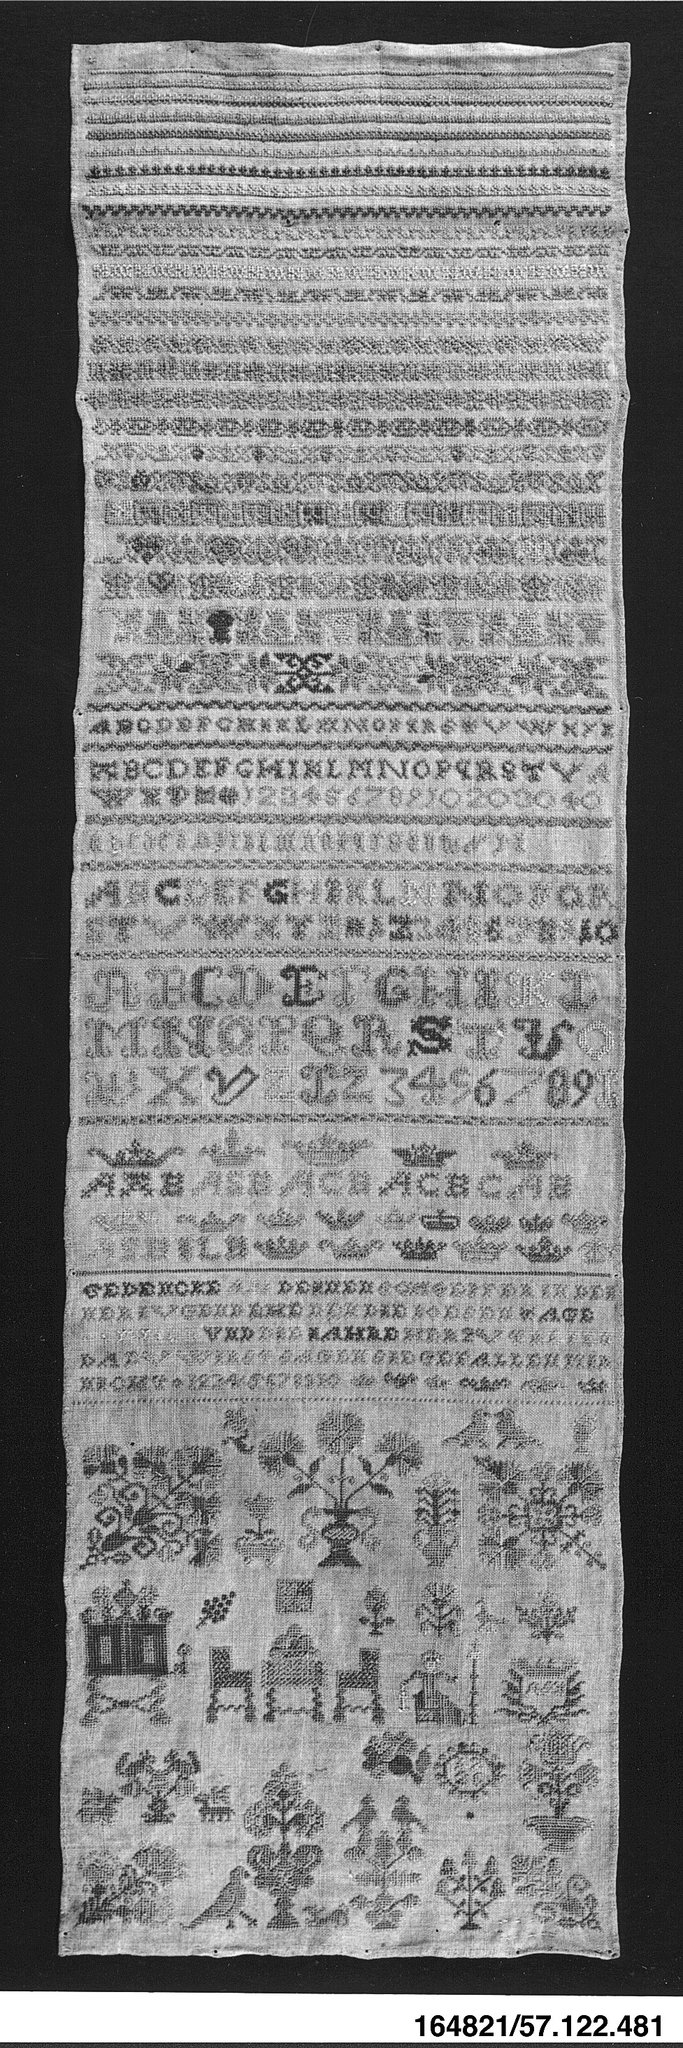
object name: sampler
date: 1726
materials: linen, silk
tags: birds,flowers